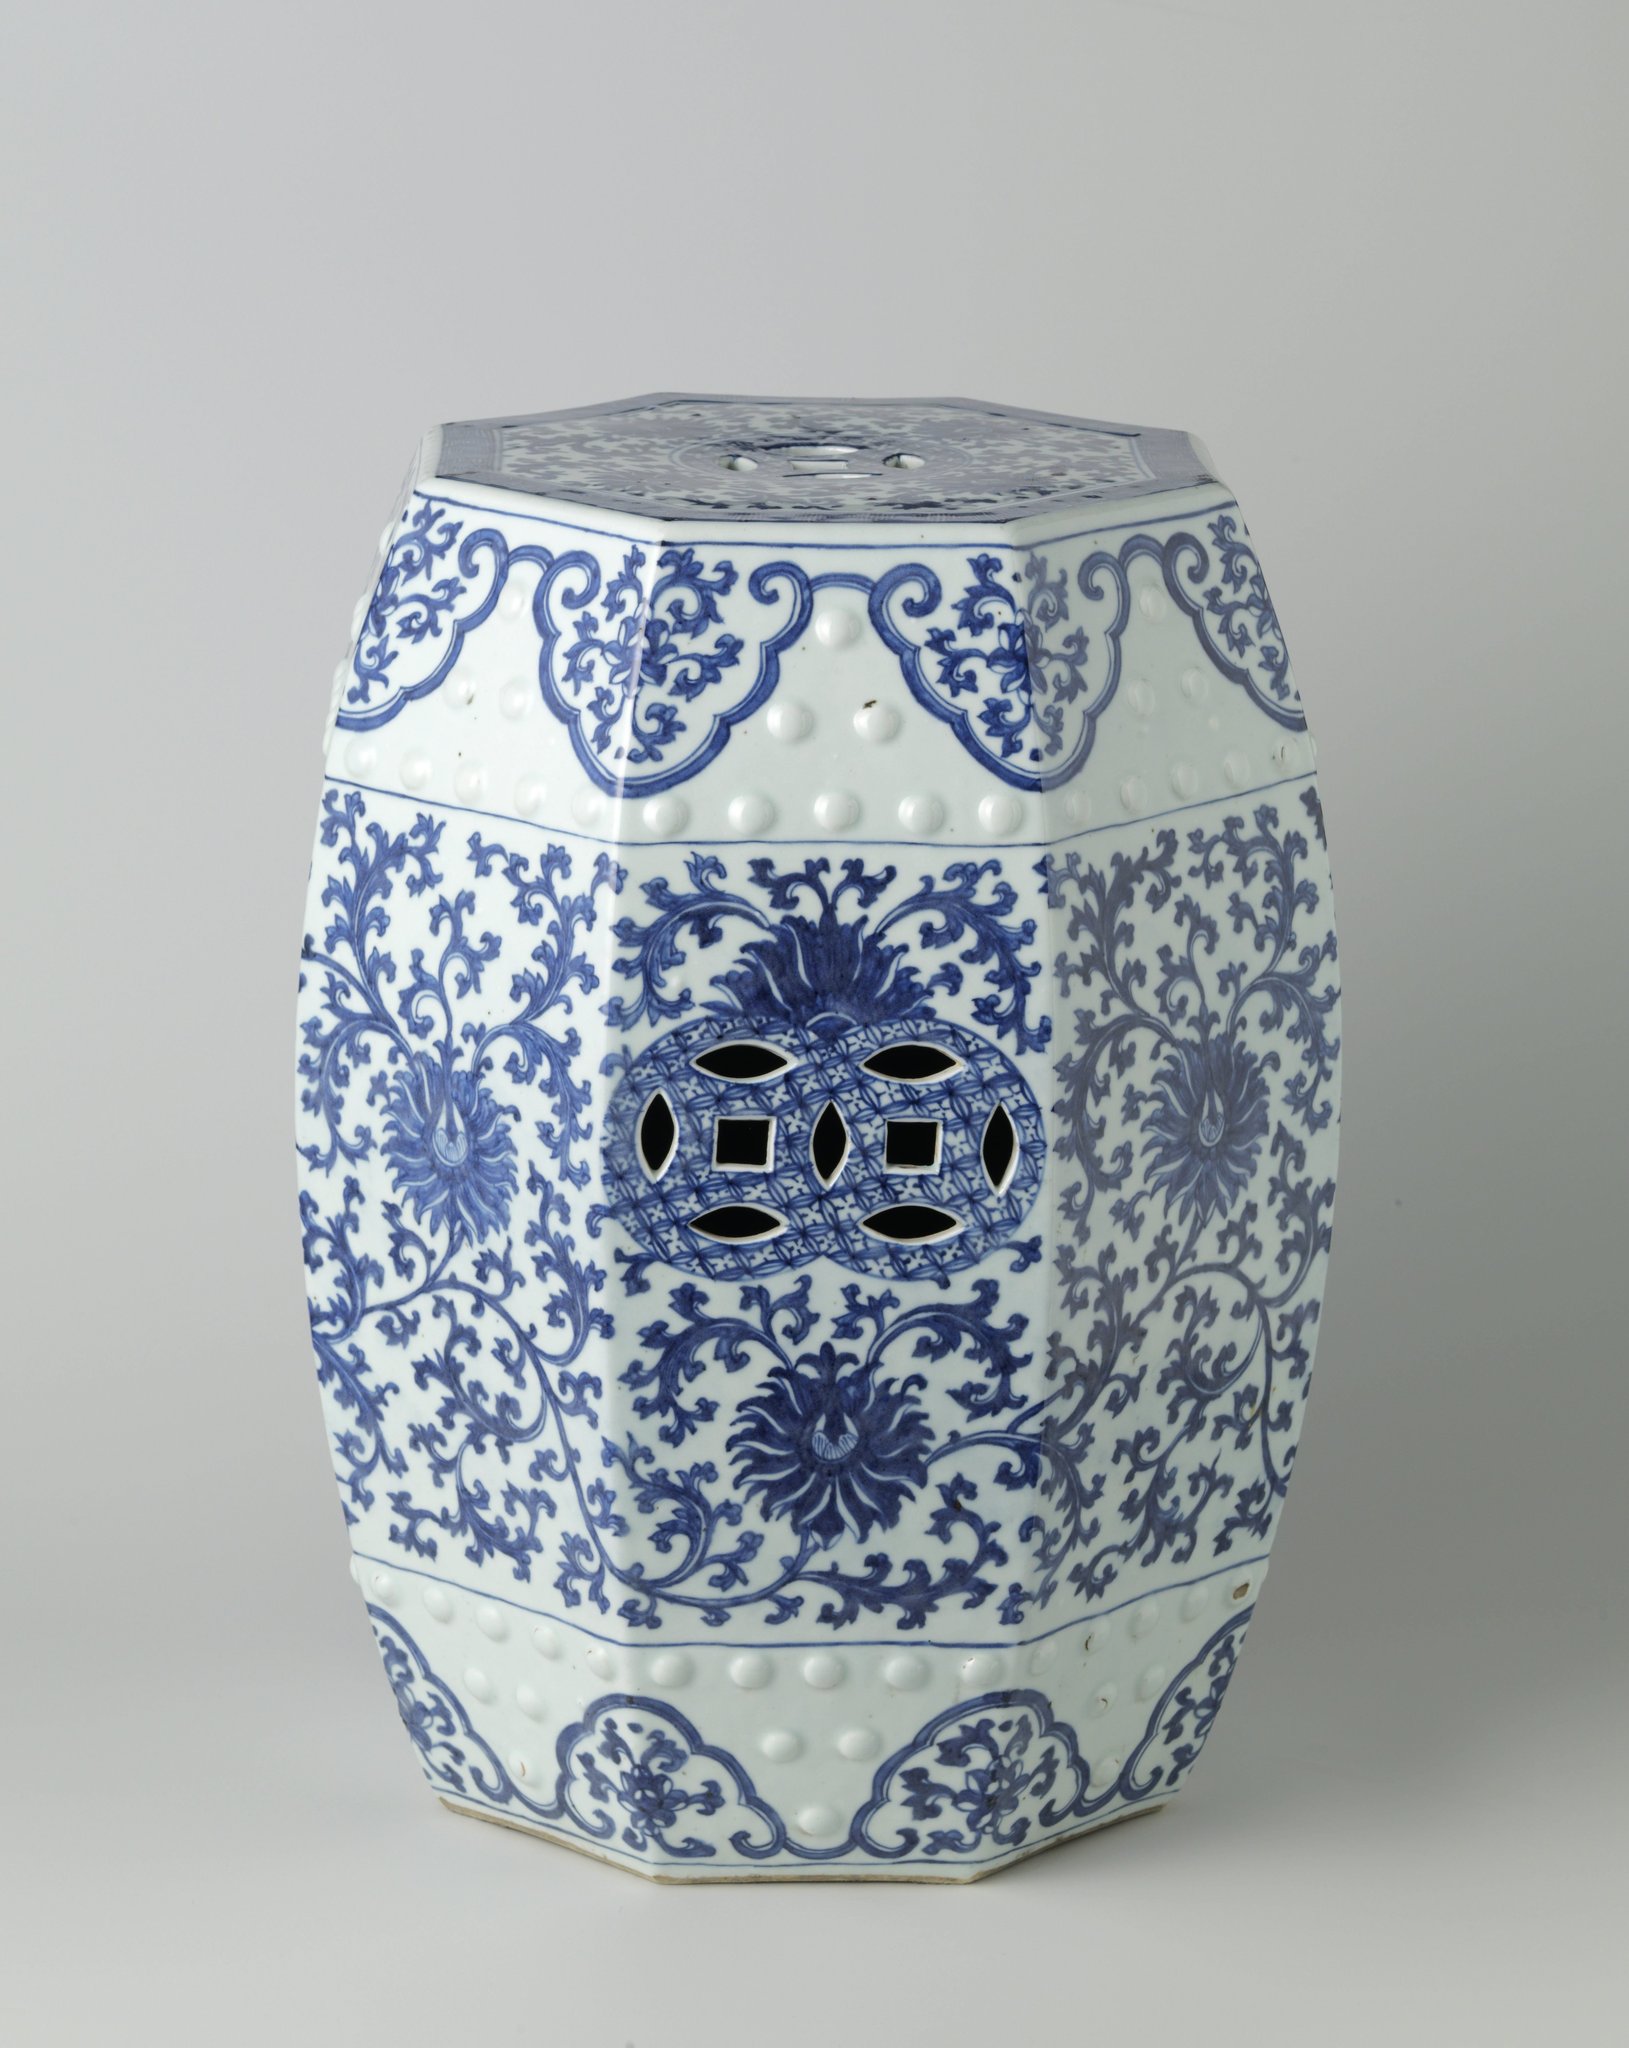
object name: tabouret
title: Octagonal garden seat with lotus scrolls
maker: Anonymous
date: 1750-1774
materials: cobalt, glaze, paint, porcelain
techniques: embroidery, firing, forming, vitrification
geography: china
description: Achthoekige taboeret of kruk van porselein, beschilderd in onderglazuur blauw. Op de wand een brede, doorlopende band met lotusranken. Op twee tegenoverliggende zijden een dubbele opengewerkte munt. Aan de onder- en bovenzijde van de wand een band met gelobde cartouches met lotusranken; daartussen noppen in reliëf. De bovenzijde met een band met lotusranken, een opengewerkt muntmotief en een band met een meanderpatroon. De onderzijde is open. Een barst in de wand. Blauw-wit.